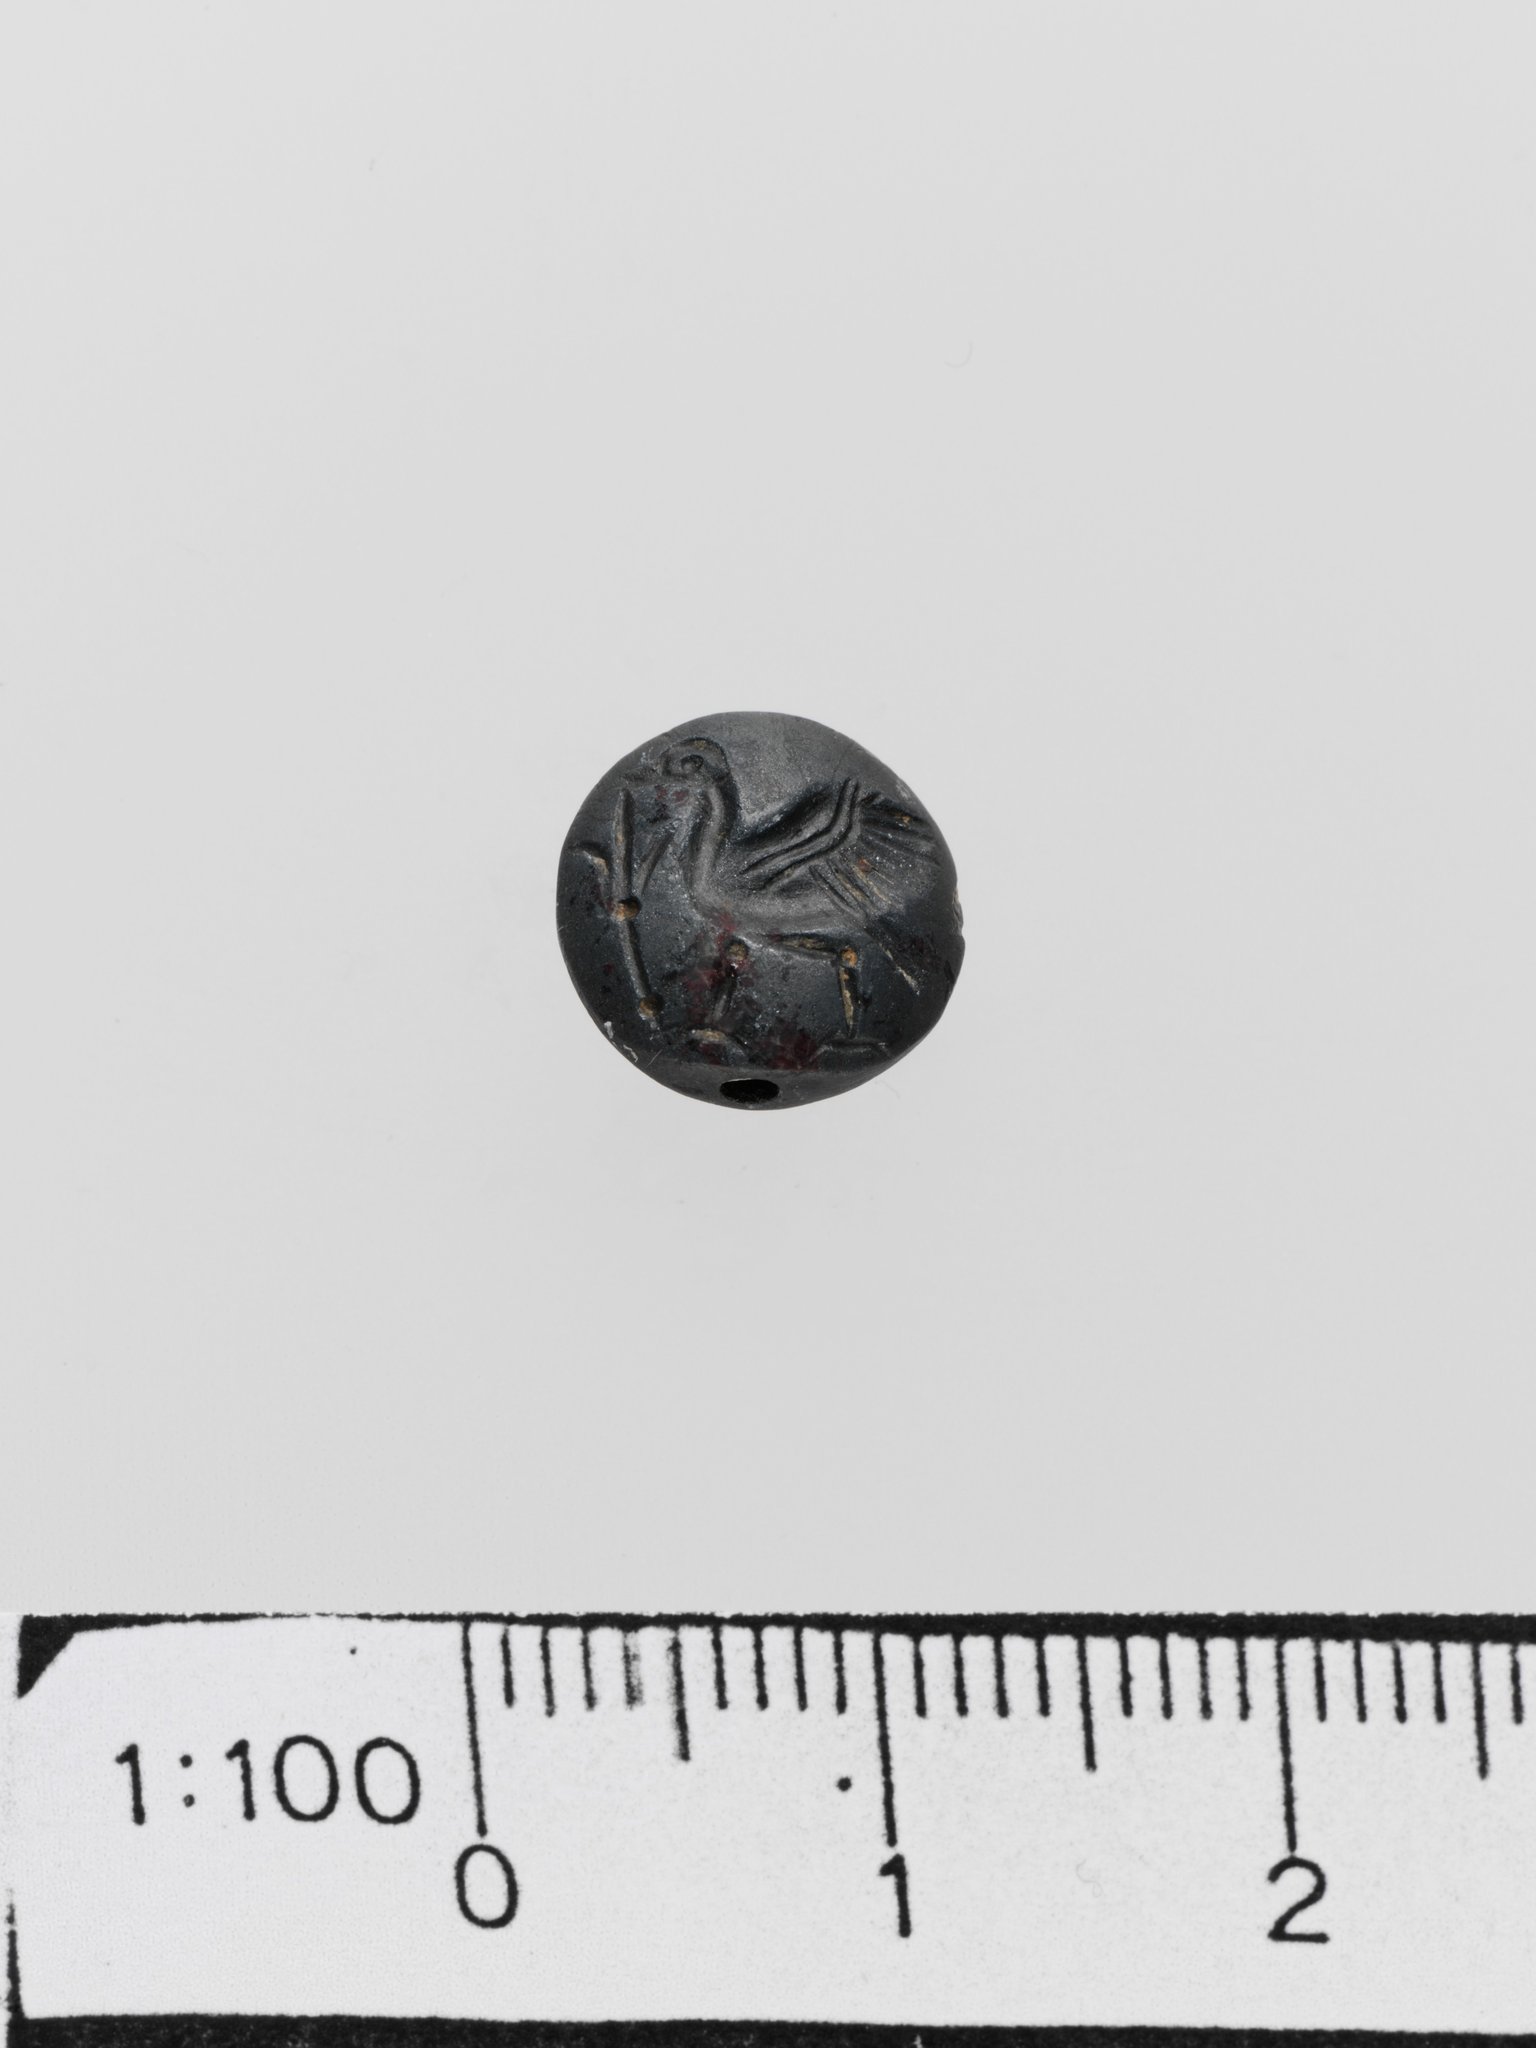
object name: seal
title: Jasper lentoid seal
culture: minoan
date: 1600-1450 BCE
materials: jasper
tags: birds